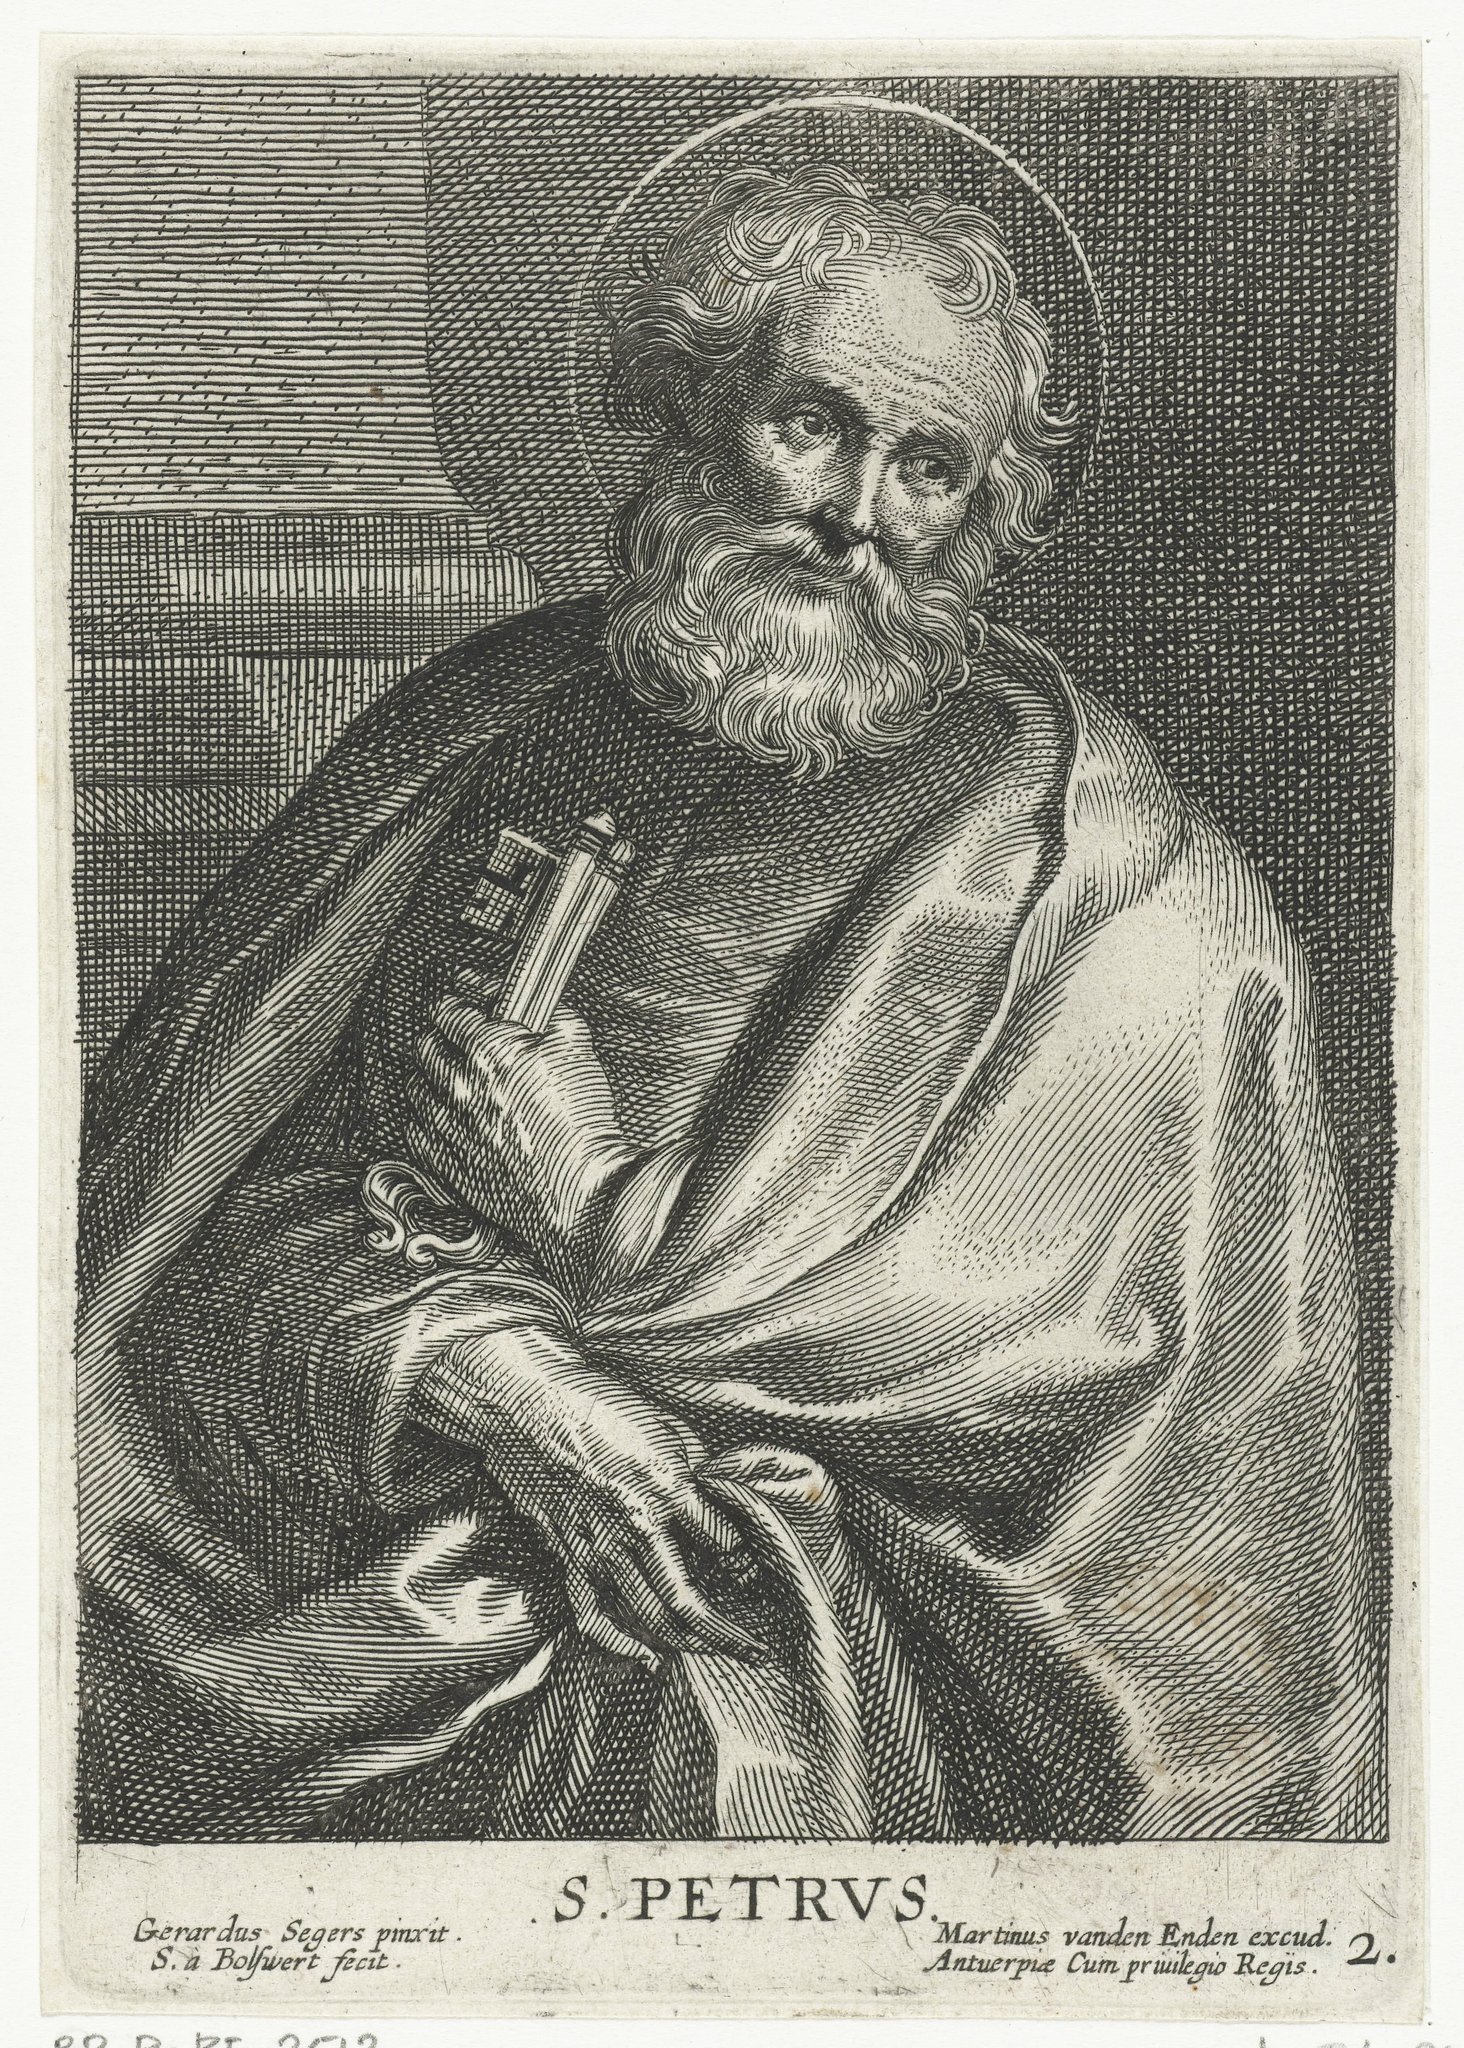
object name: print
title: S. Petrvs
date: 1596-1659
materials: paper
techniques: engraving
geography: antwerp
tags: the apostle peter, first bishop of rome; possible attributes: book, cock, (upturned) cross, (triple) crozier, fish, key, scroll, ship, tiara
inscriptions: collector's mark: Lugt 240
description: Prent uit serie met veertien prenten met Christus, Paulus en twaalf apostelen naar schilderijen van Gerard Seghers.